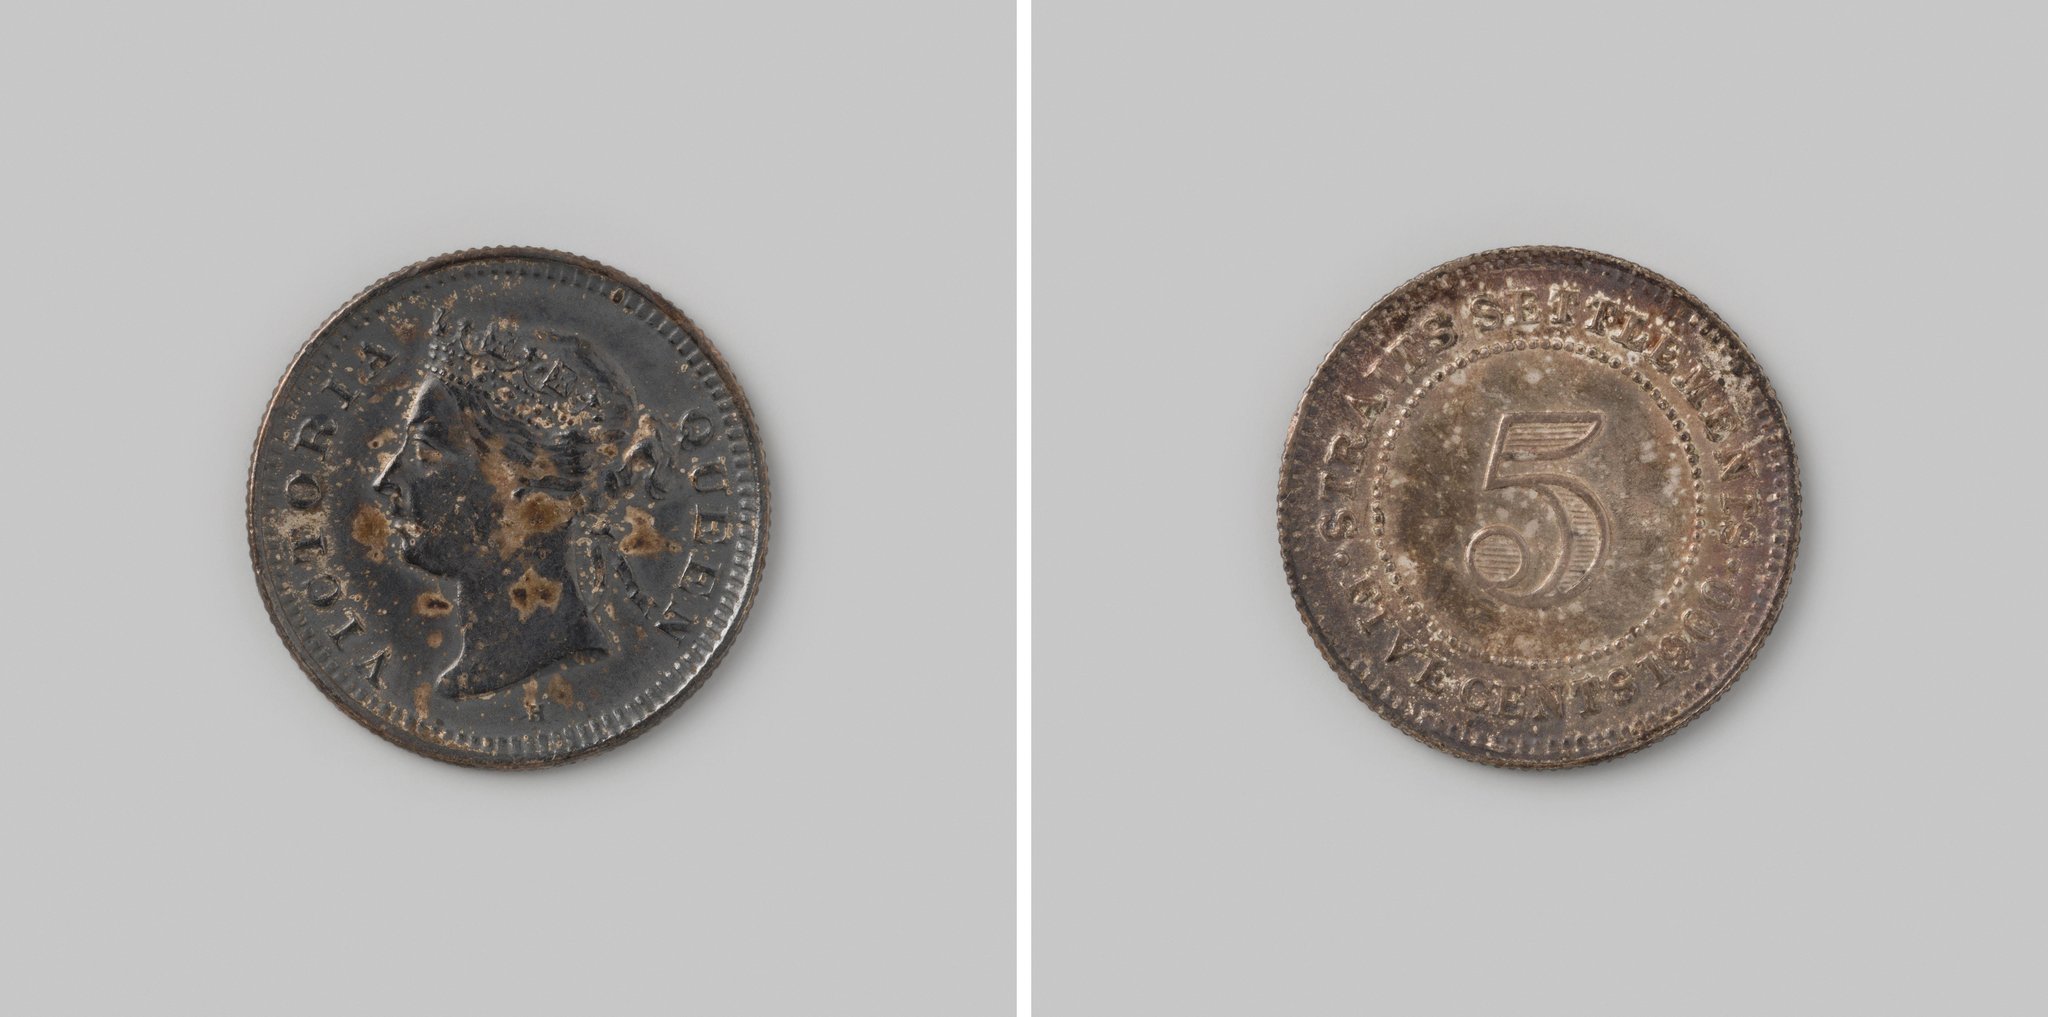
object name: coin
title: 5 cents uit de Straits Settlements van koningin Victoria, 1900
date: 1900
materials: silver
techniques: striking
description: Zilveren munt. Voorzijde: gekroond hoofd van koningin Victoria naar links. Keerzijde: binnen parelcirkel waarde-aanduiding: 5. In omschrift onderaan waarde-aanduiding: five cents met rechts daarvan jaartal. Kartelrand.